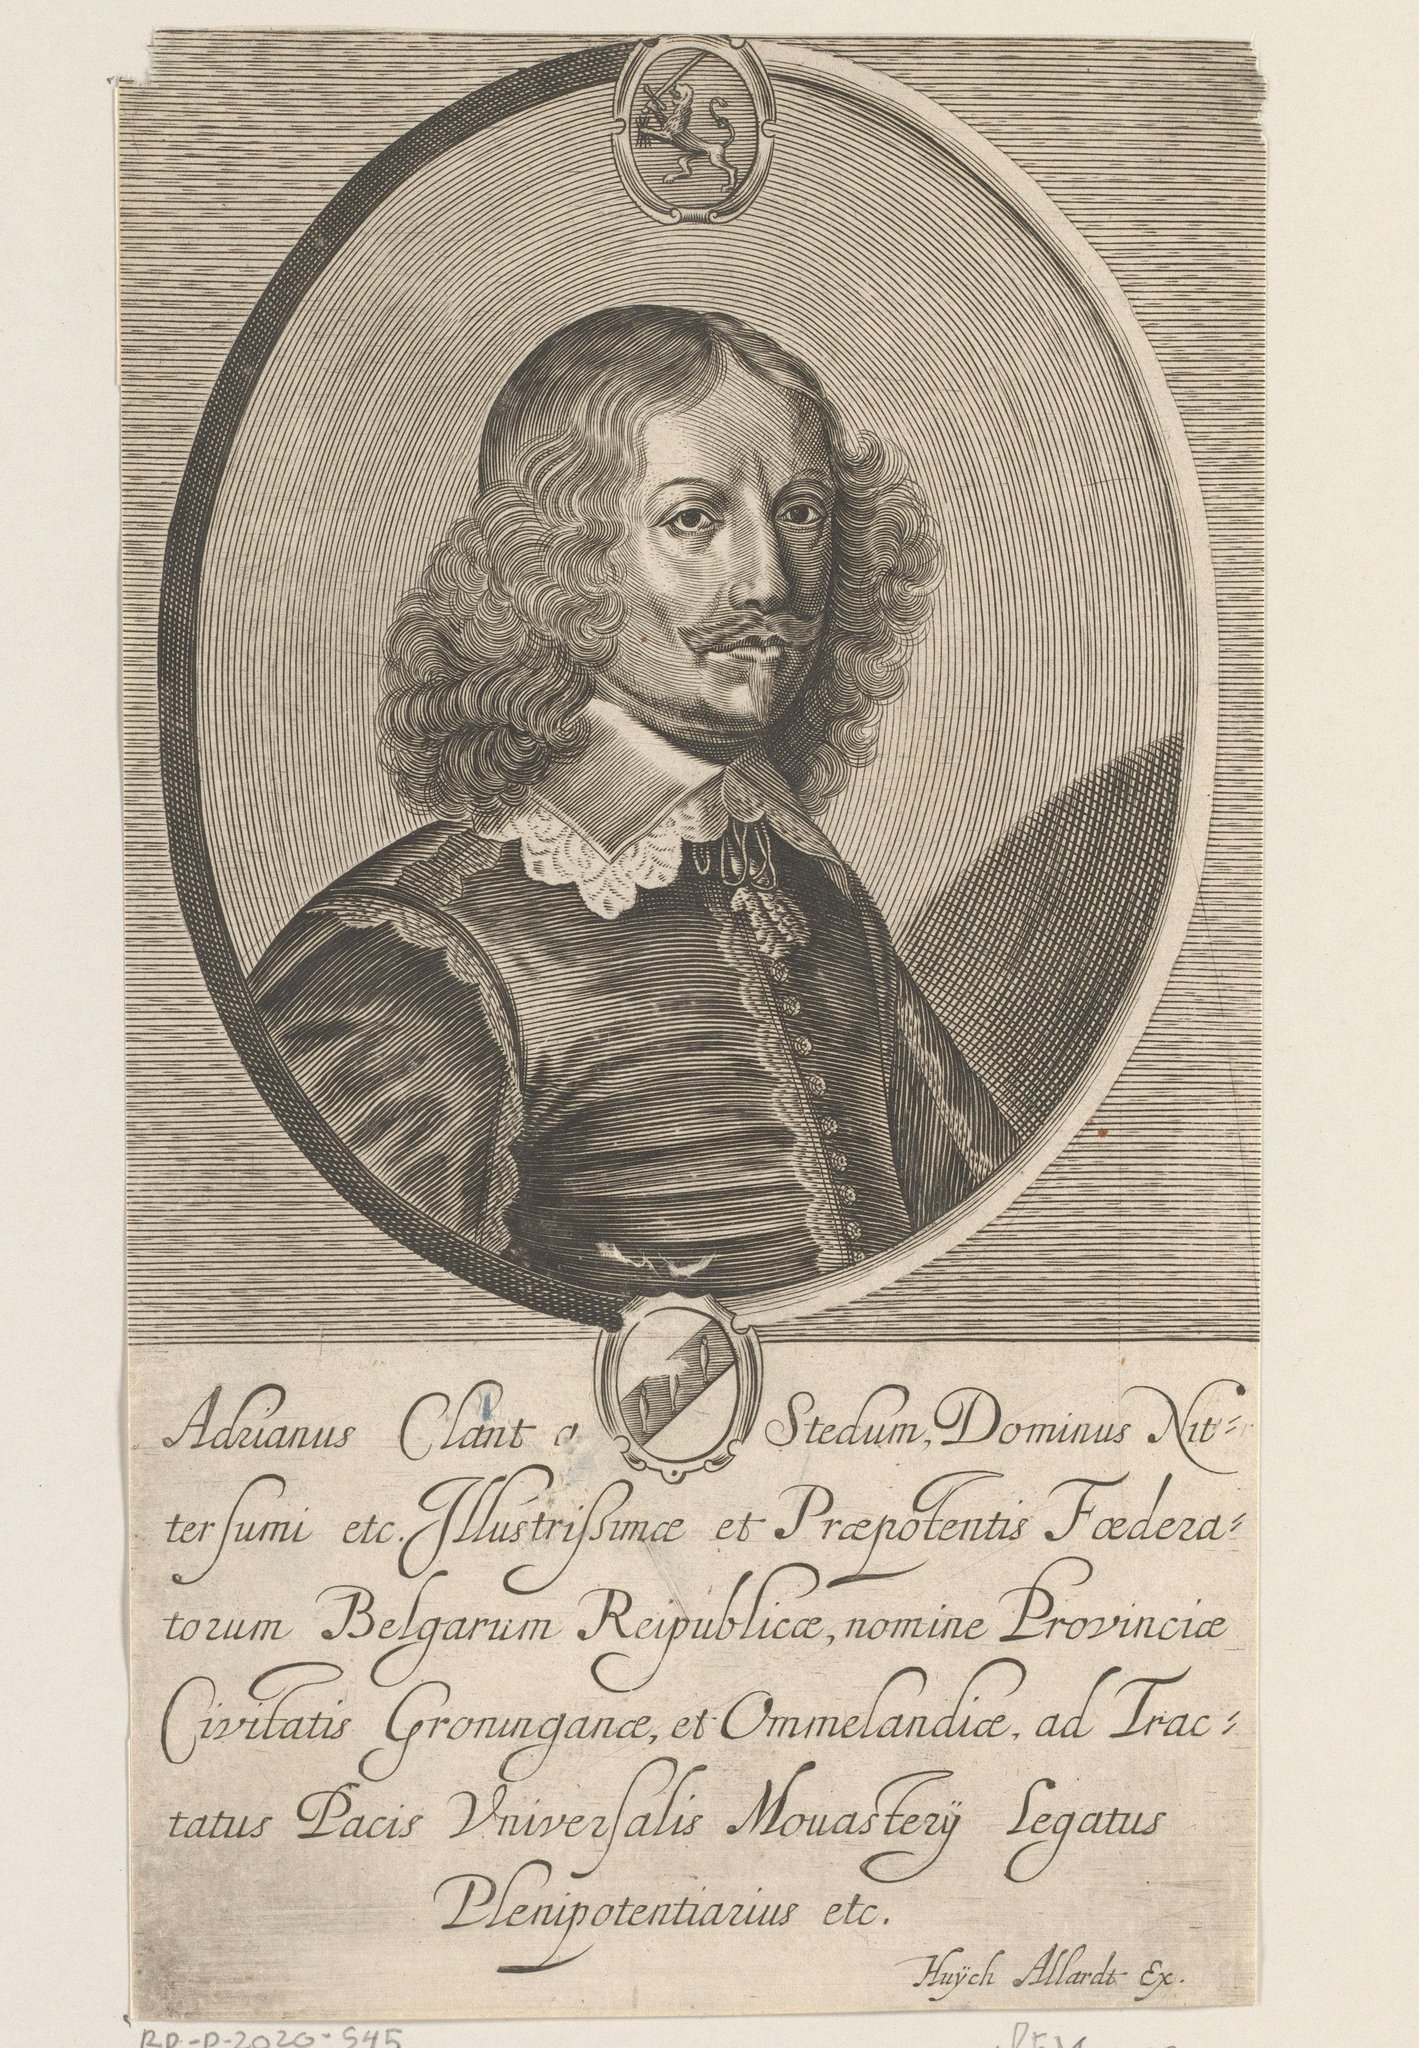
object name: print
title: Portret van Adriaen Clant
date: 1640-1684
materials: paper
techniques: engraving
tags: historical persons, diplomacy, diplomat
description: In een ovaal met onder en boven een wapenschild. Onder het portret een tekst.